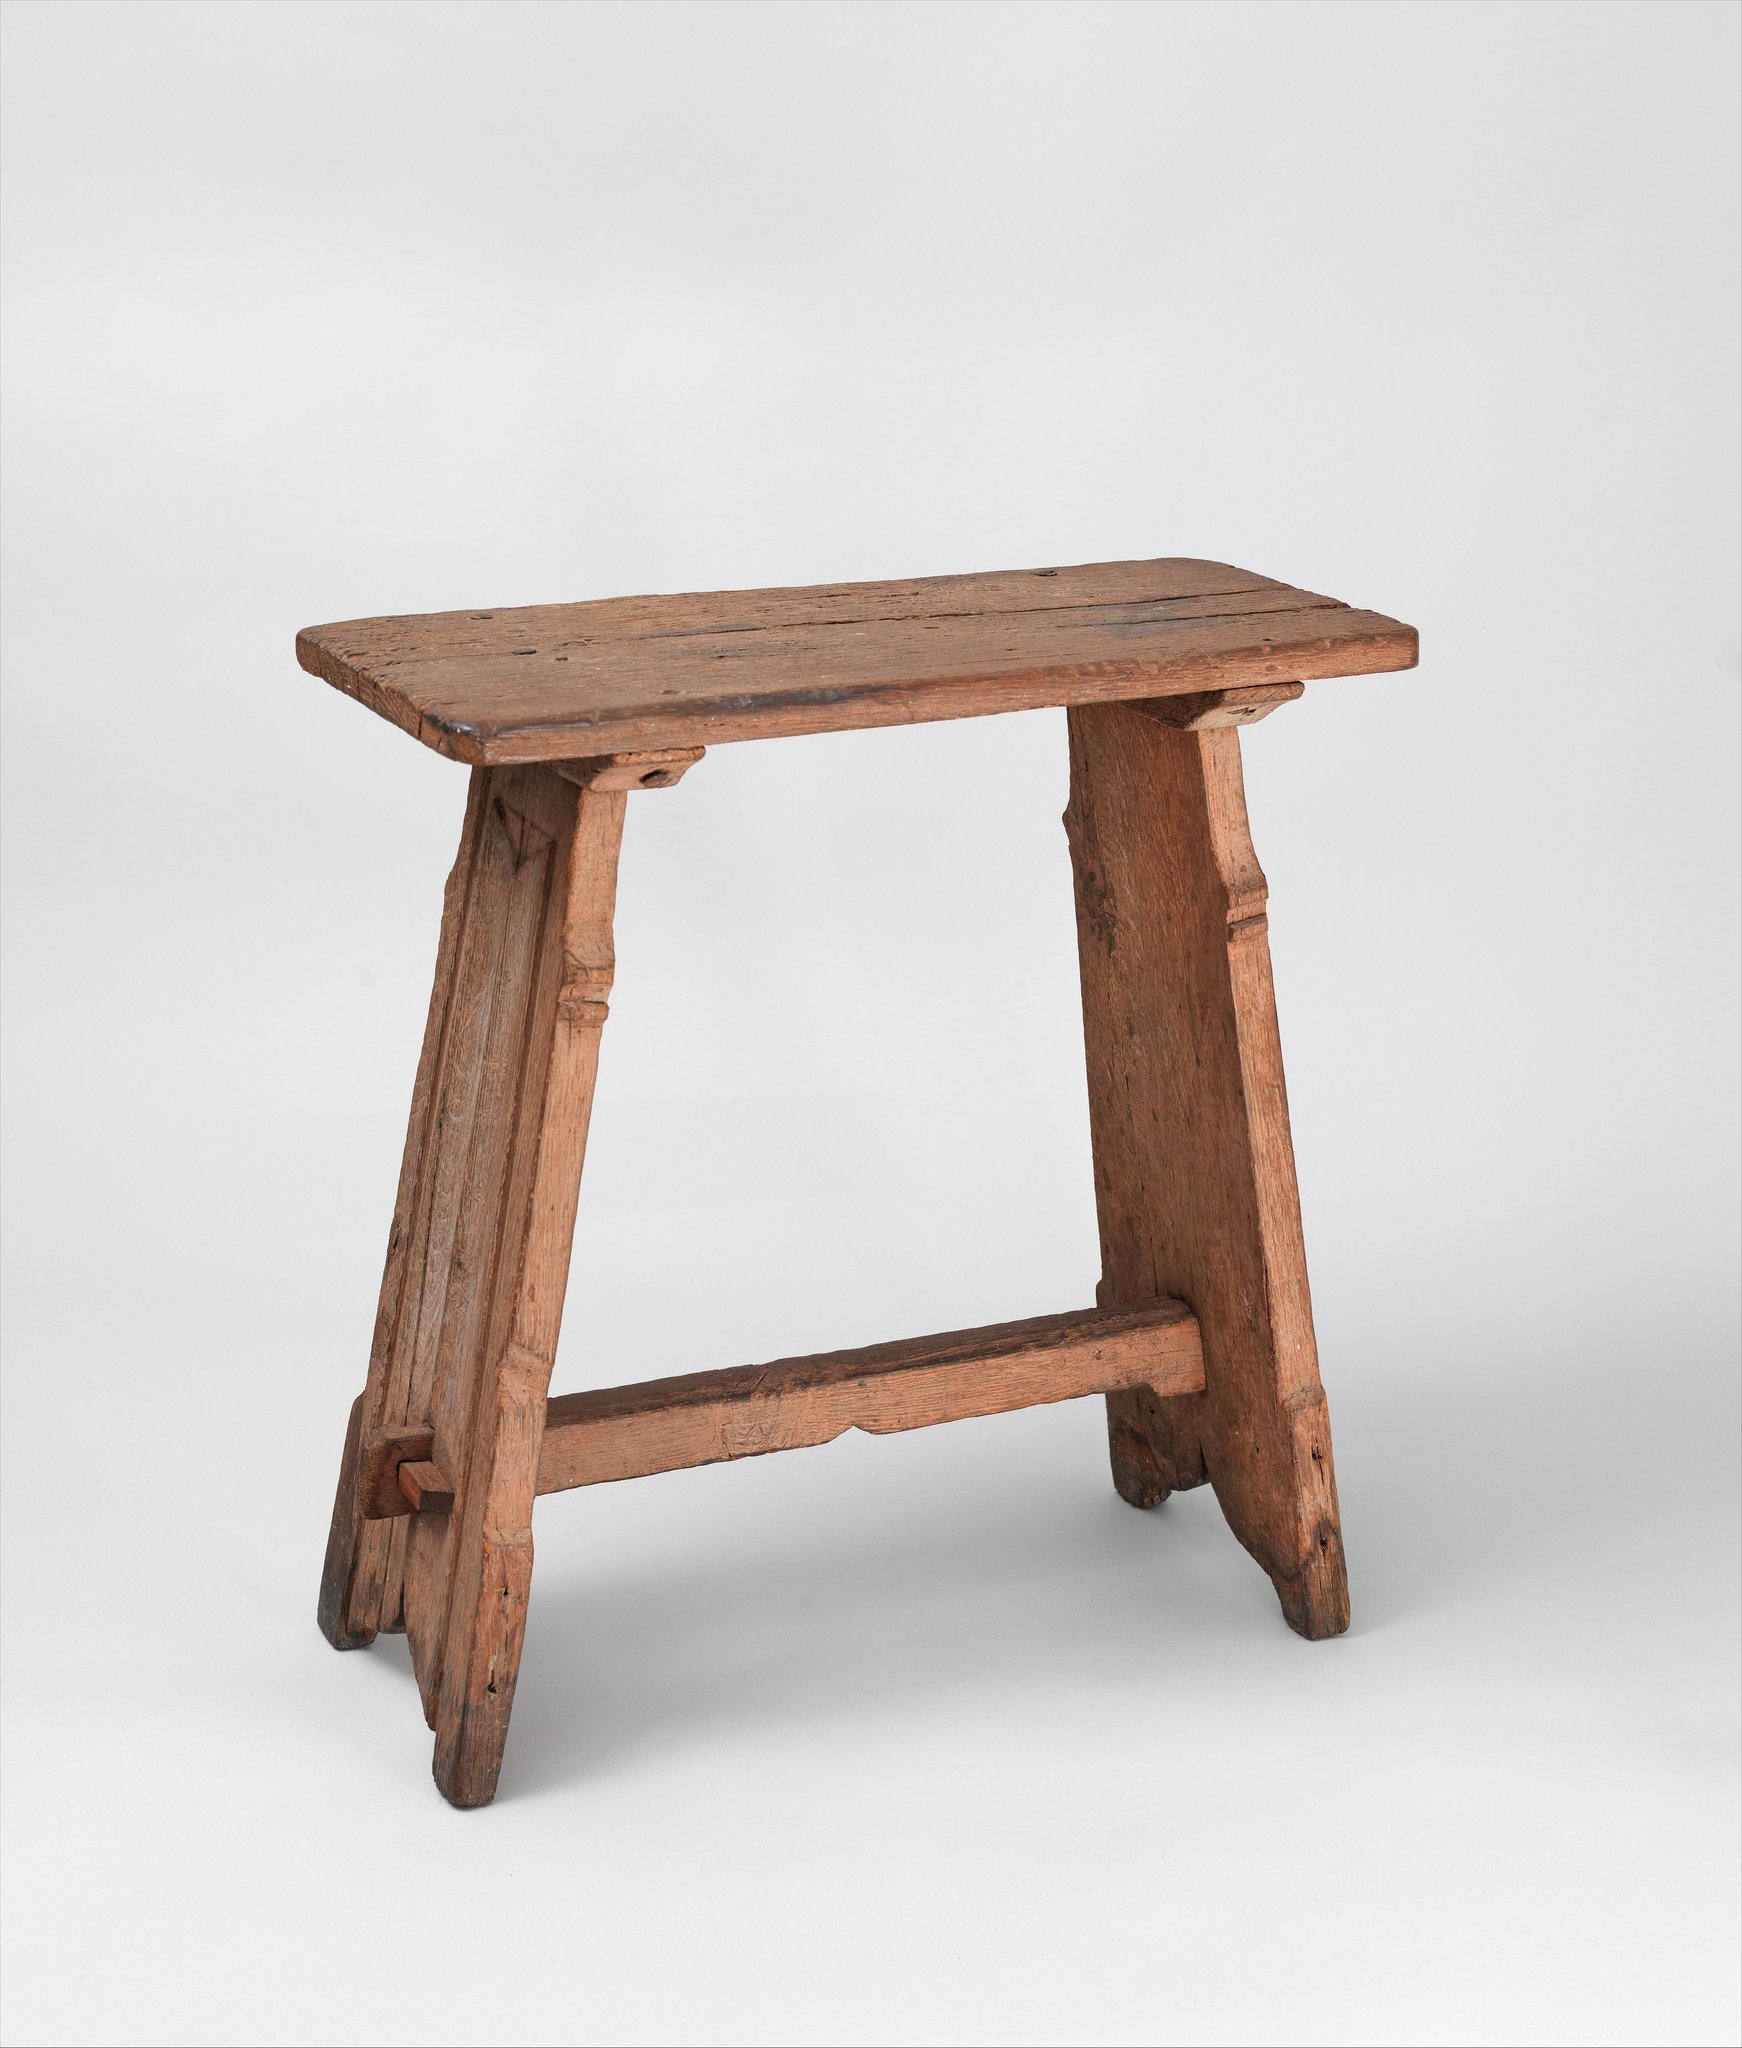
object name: stool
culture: french or south netherlandish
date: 1401-1500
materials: wood